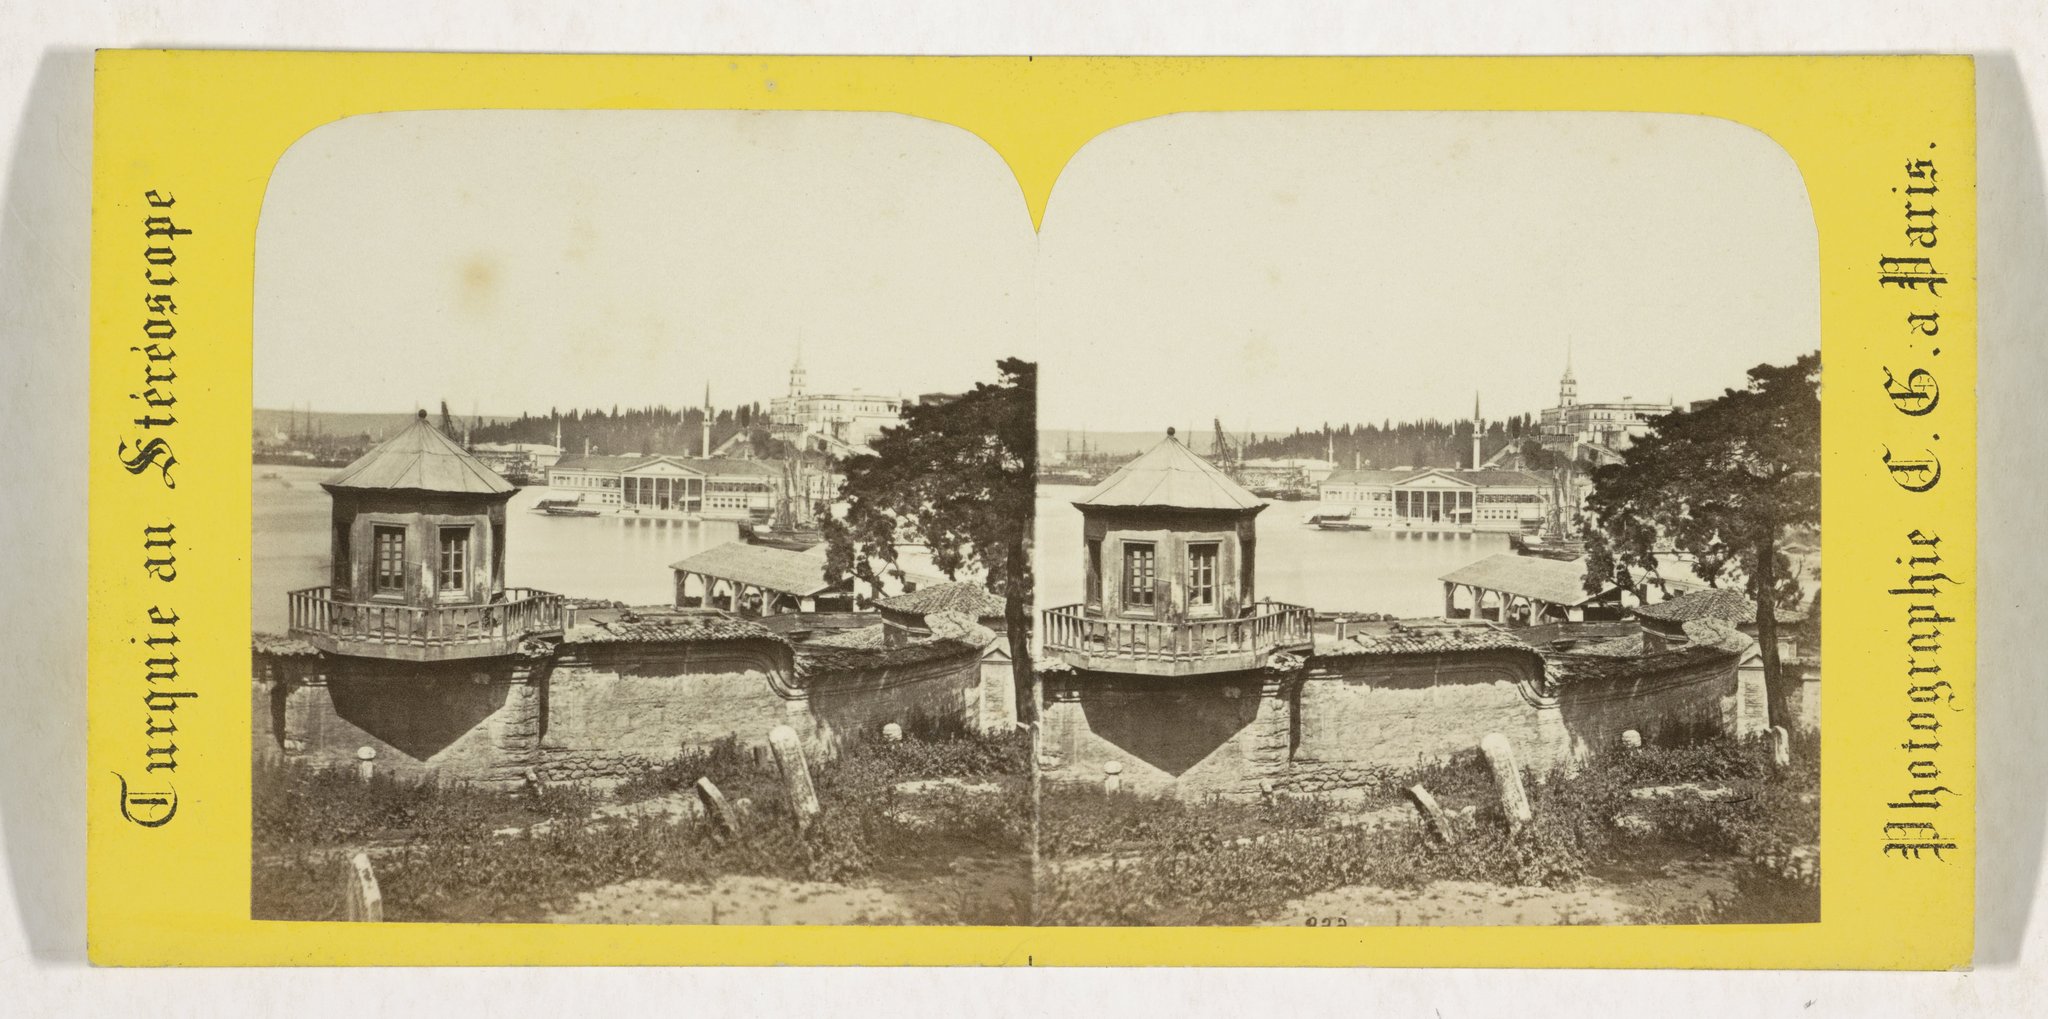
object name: stereograph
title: Tersâne-i Âmire haven in Istanboel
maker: charles gaudin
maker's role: publisher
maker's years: 1825-1905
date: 1861-1870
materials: cardboard, paper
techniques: albumen print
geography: imperial arsenal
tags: harbour, imperial arsenal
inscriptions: number: ‘322 [?]’